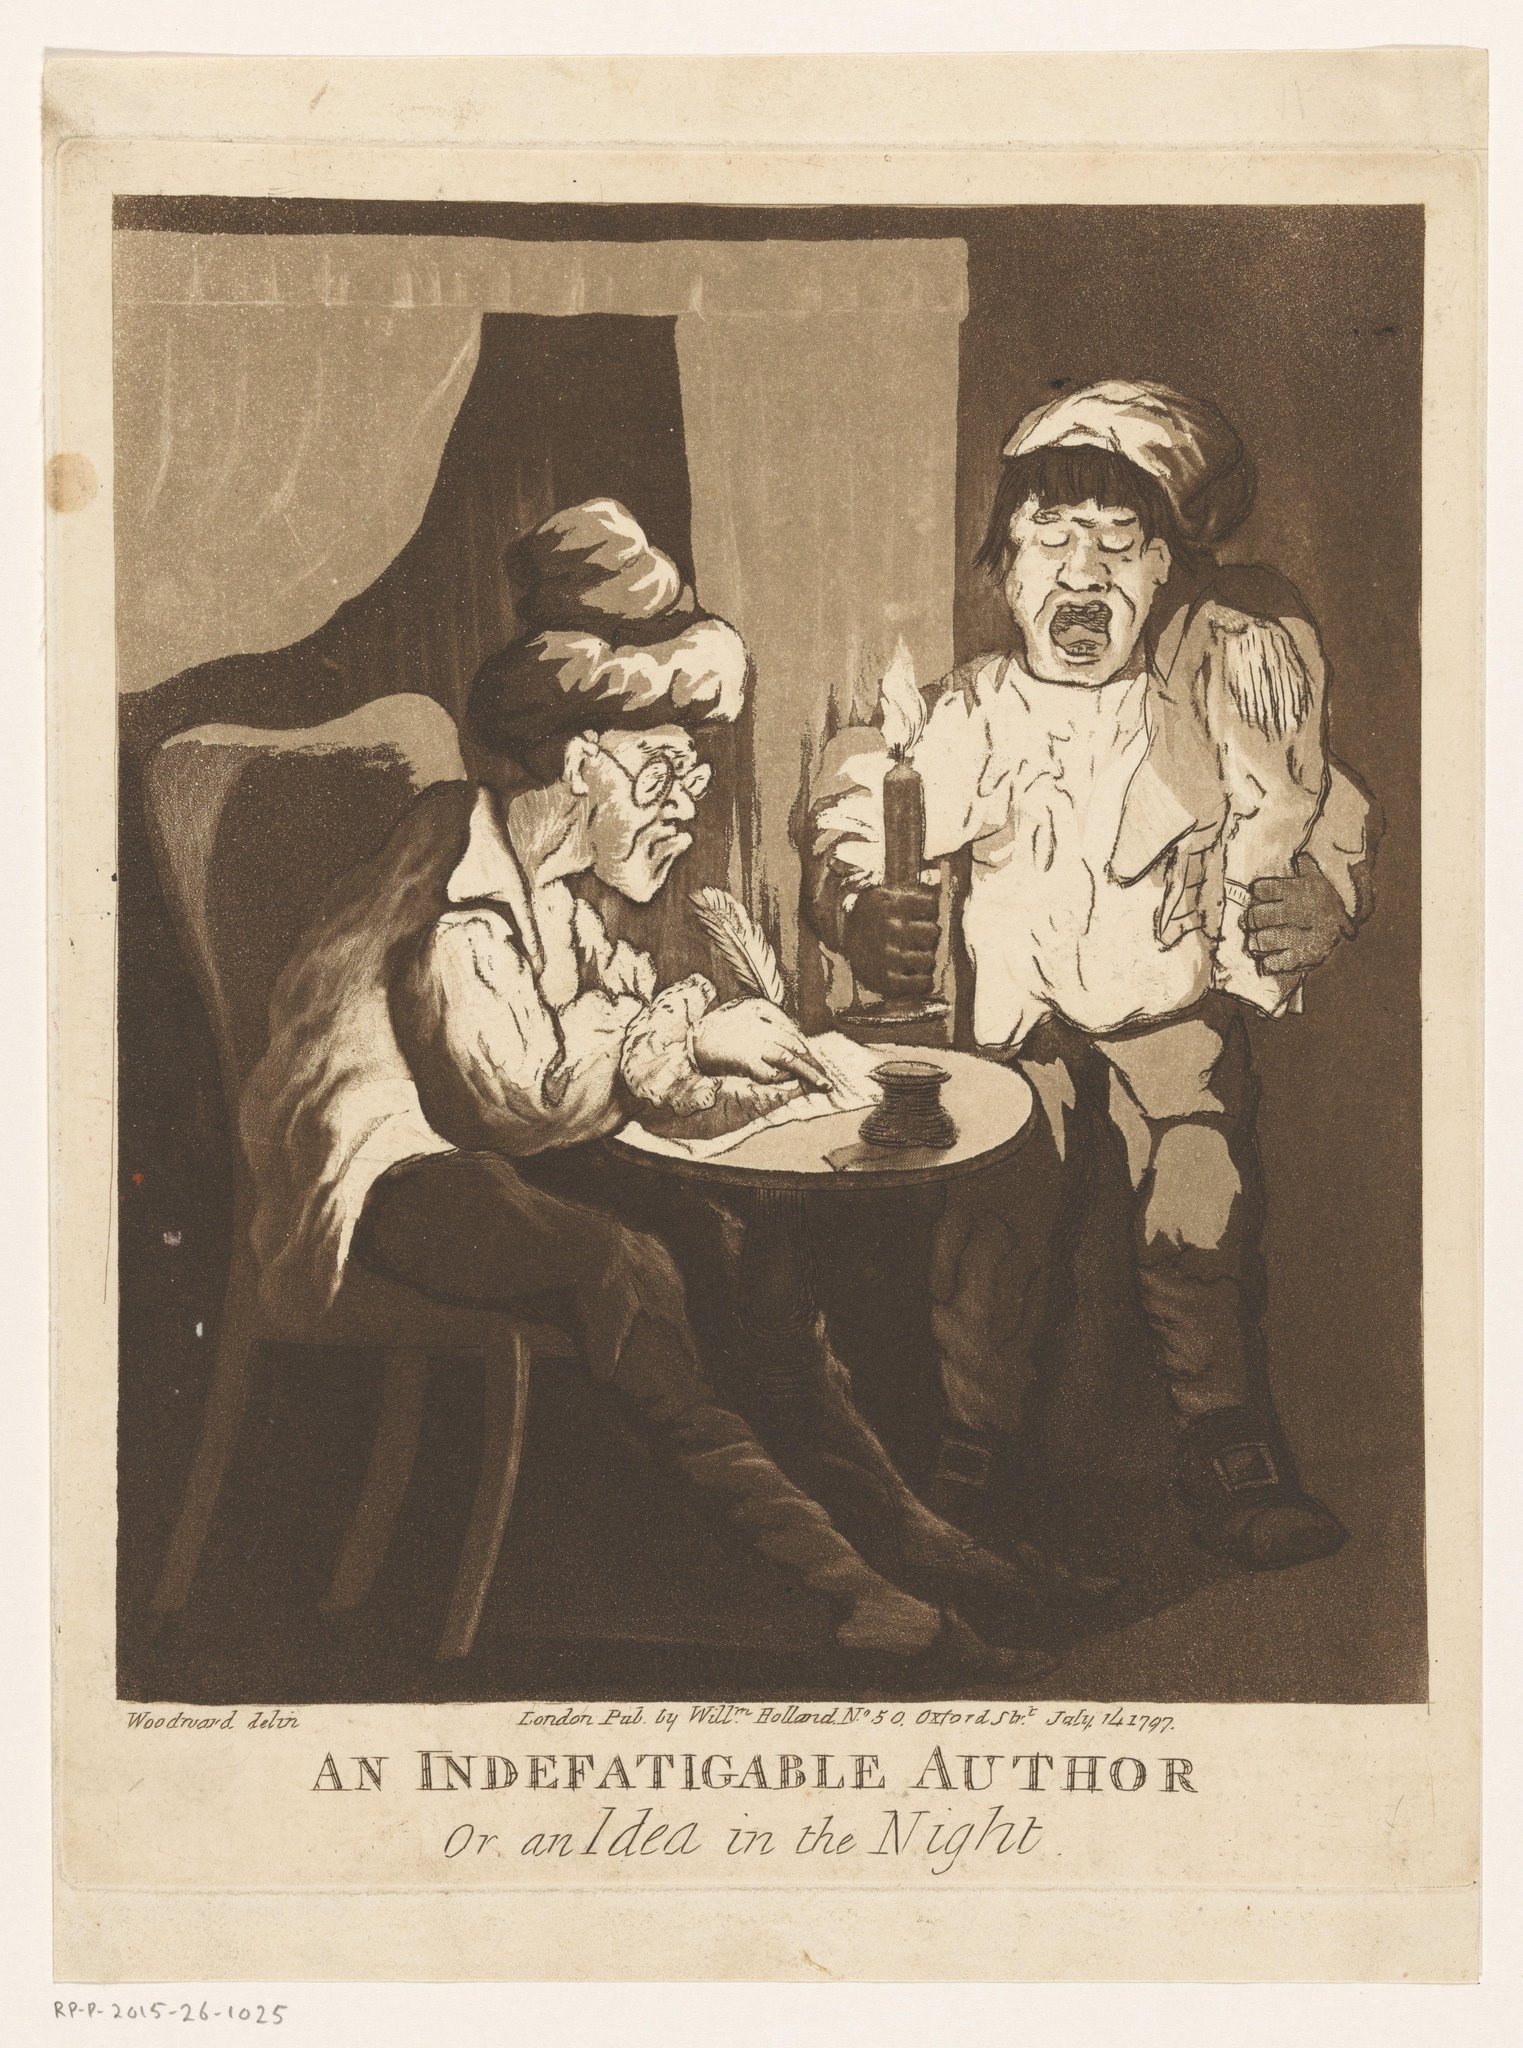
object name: print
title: An Indefatigable Author Or an Idea in the Night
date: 1707-1797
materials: paper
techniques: aquatint, etching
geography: london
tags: ink-well, author, poet writing, manservant, footman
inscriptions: collector's mark: Lugt 4779, collector's mark: Lugt 2228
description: Naast de auteur staat een slaperige bediende met een kaars in zijn hand.